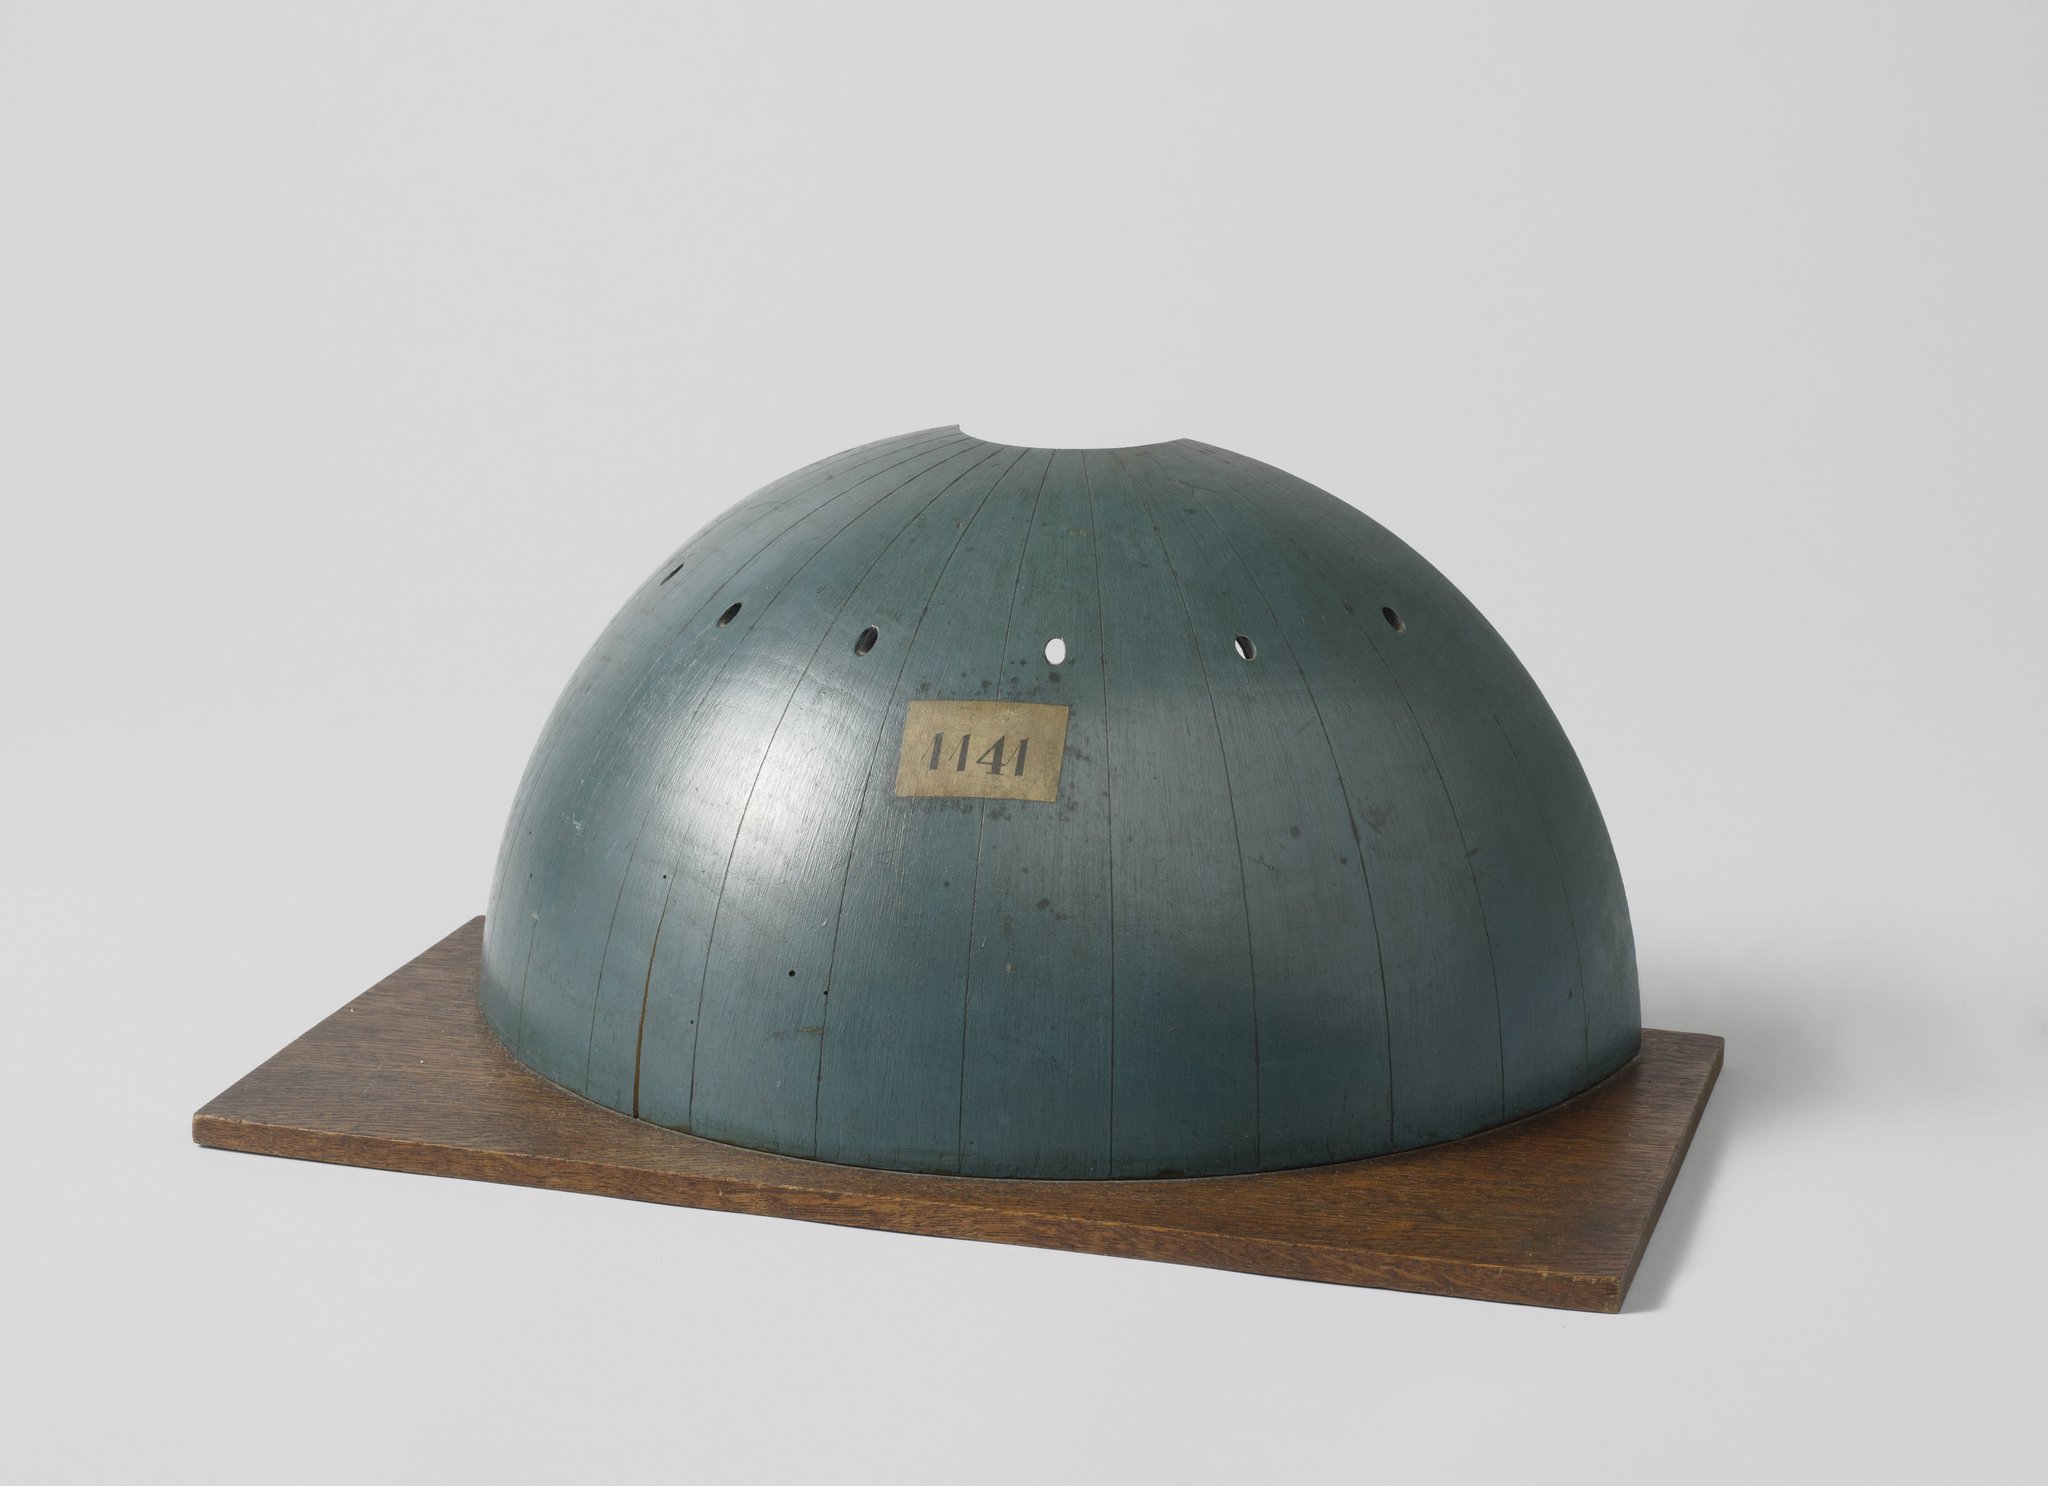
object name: demonstration model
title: Model of a section of an armoured turret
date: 1862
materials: wood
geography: flushing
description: The process of converting large sailing ships into floating artillery batteries led to a stream of innovations. One example is this armoured turret, from behind which riflemen could safely fire their weapons at the enemy.